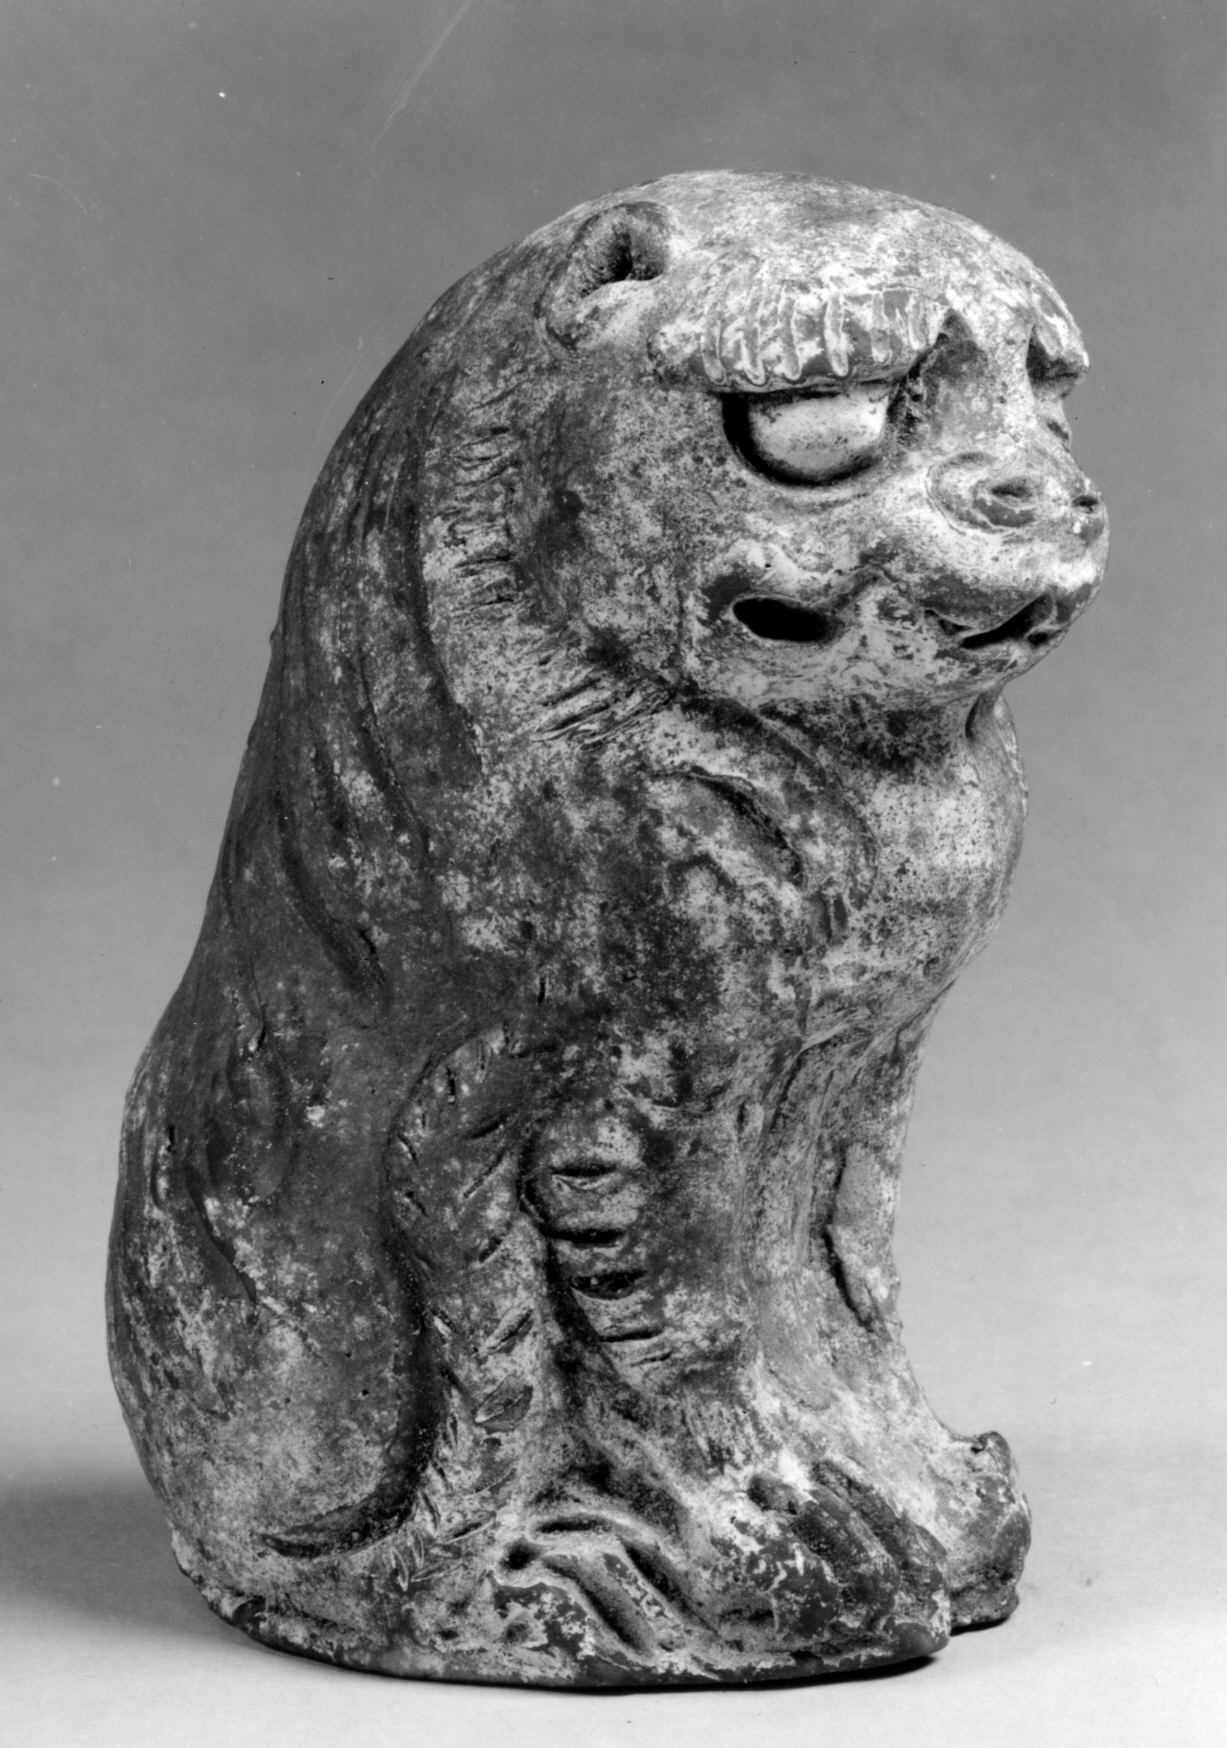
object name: tomb figure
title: Tomb Figure of Seated Lion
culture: chinese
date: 201-600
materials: earthenware, pigment, pottery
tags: lions